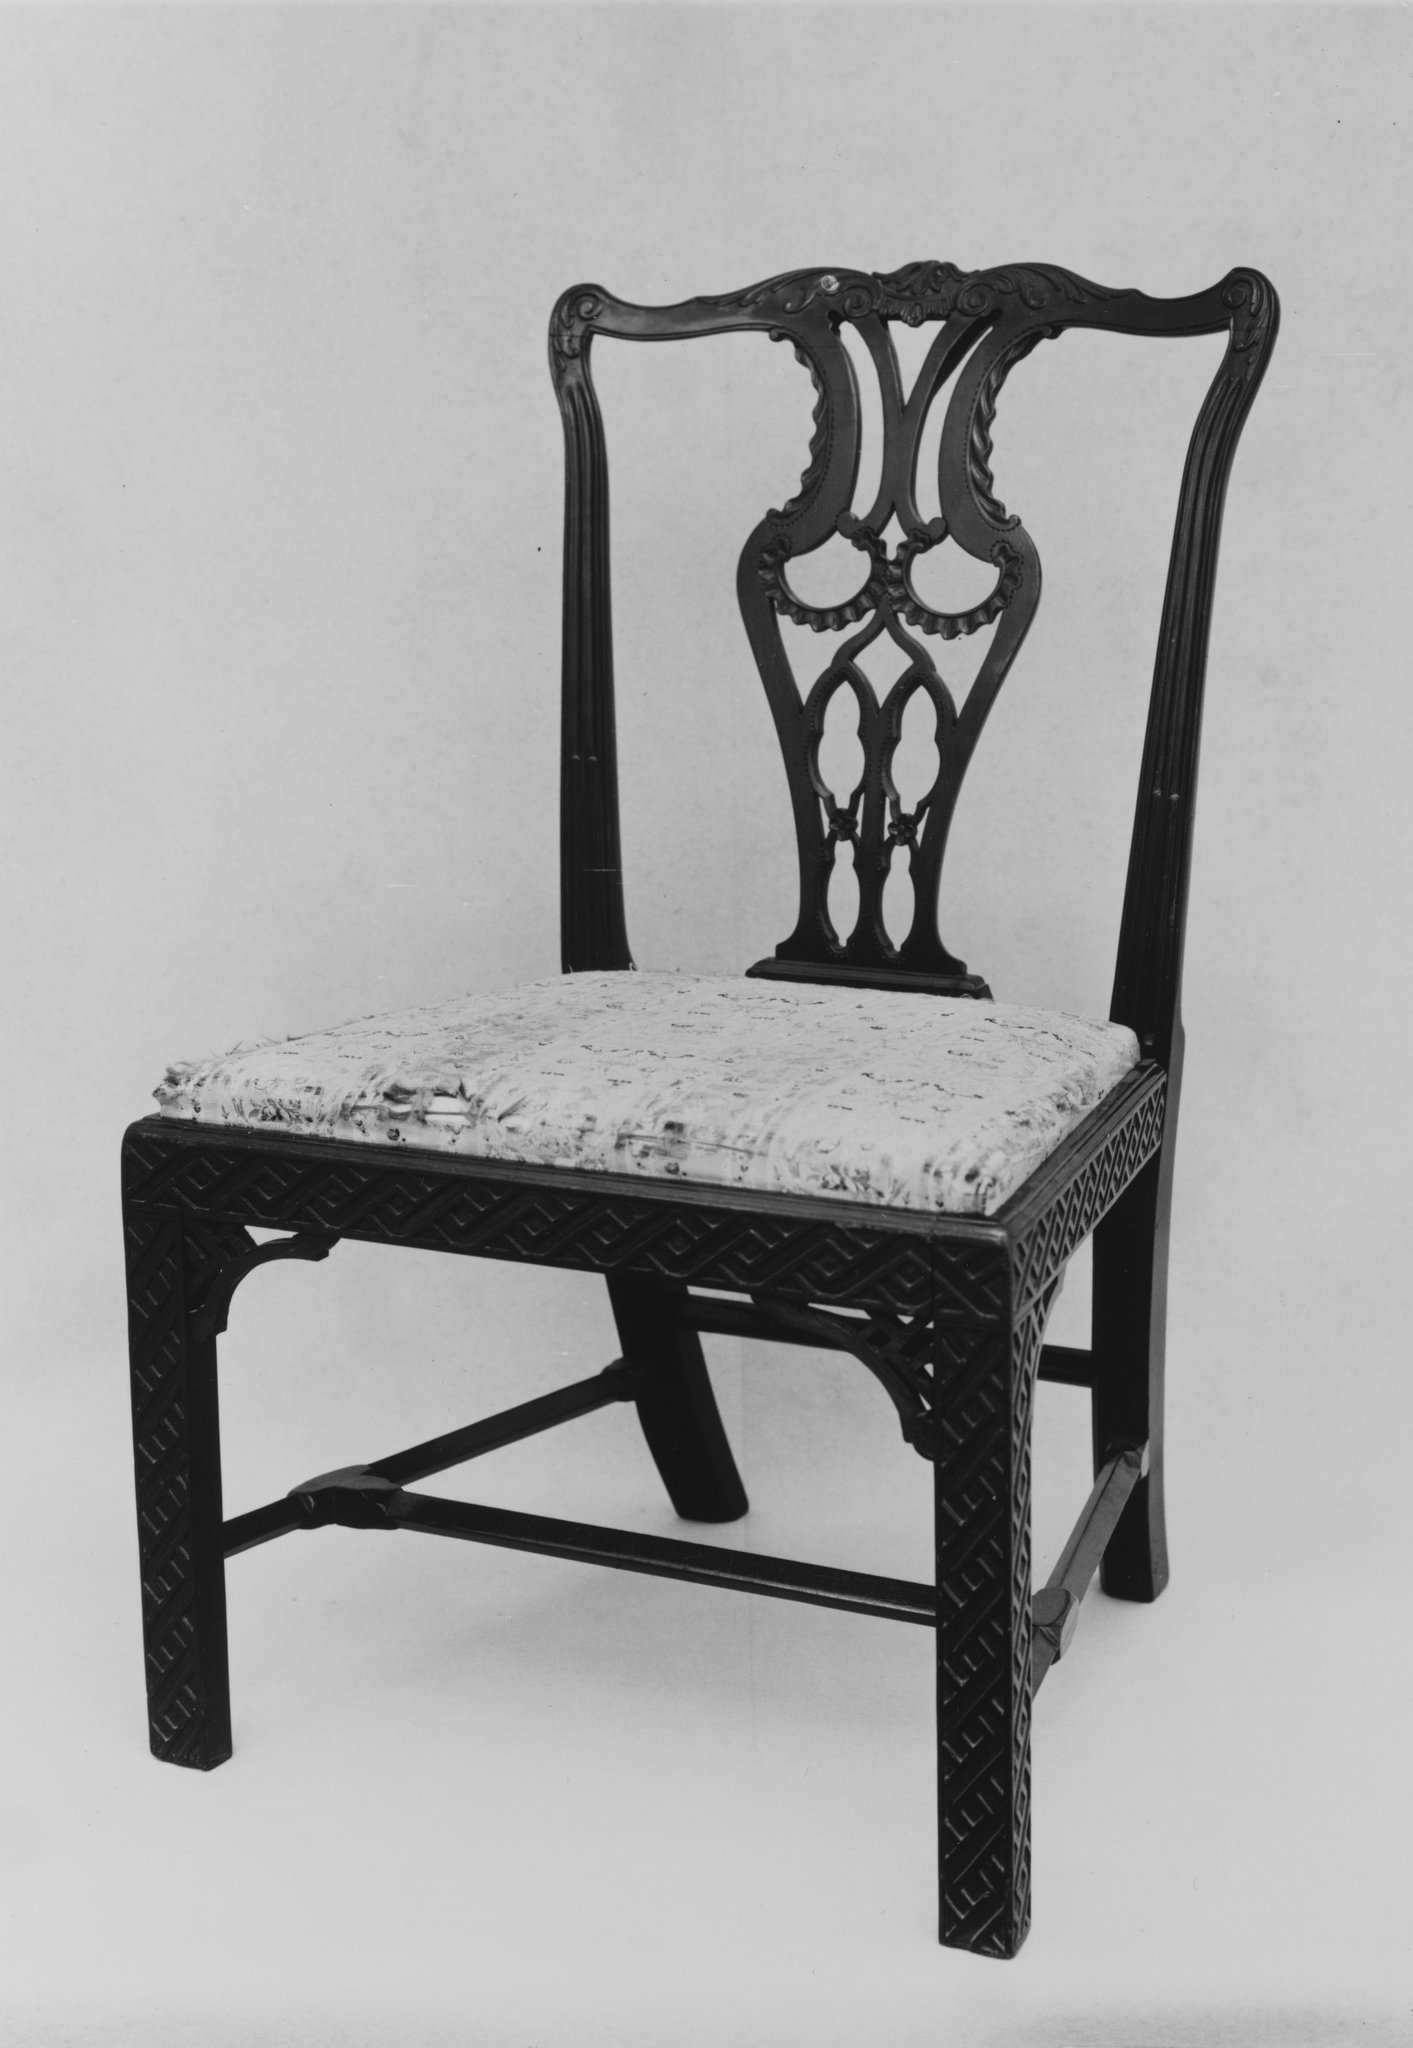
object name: side chair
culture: british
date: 1750-1770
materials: wood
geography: england